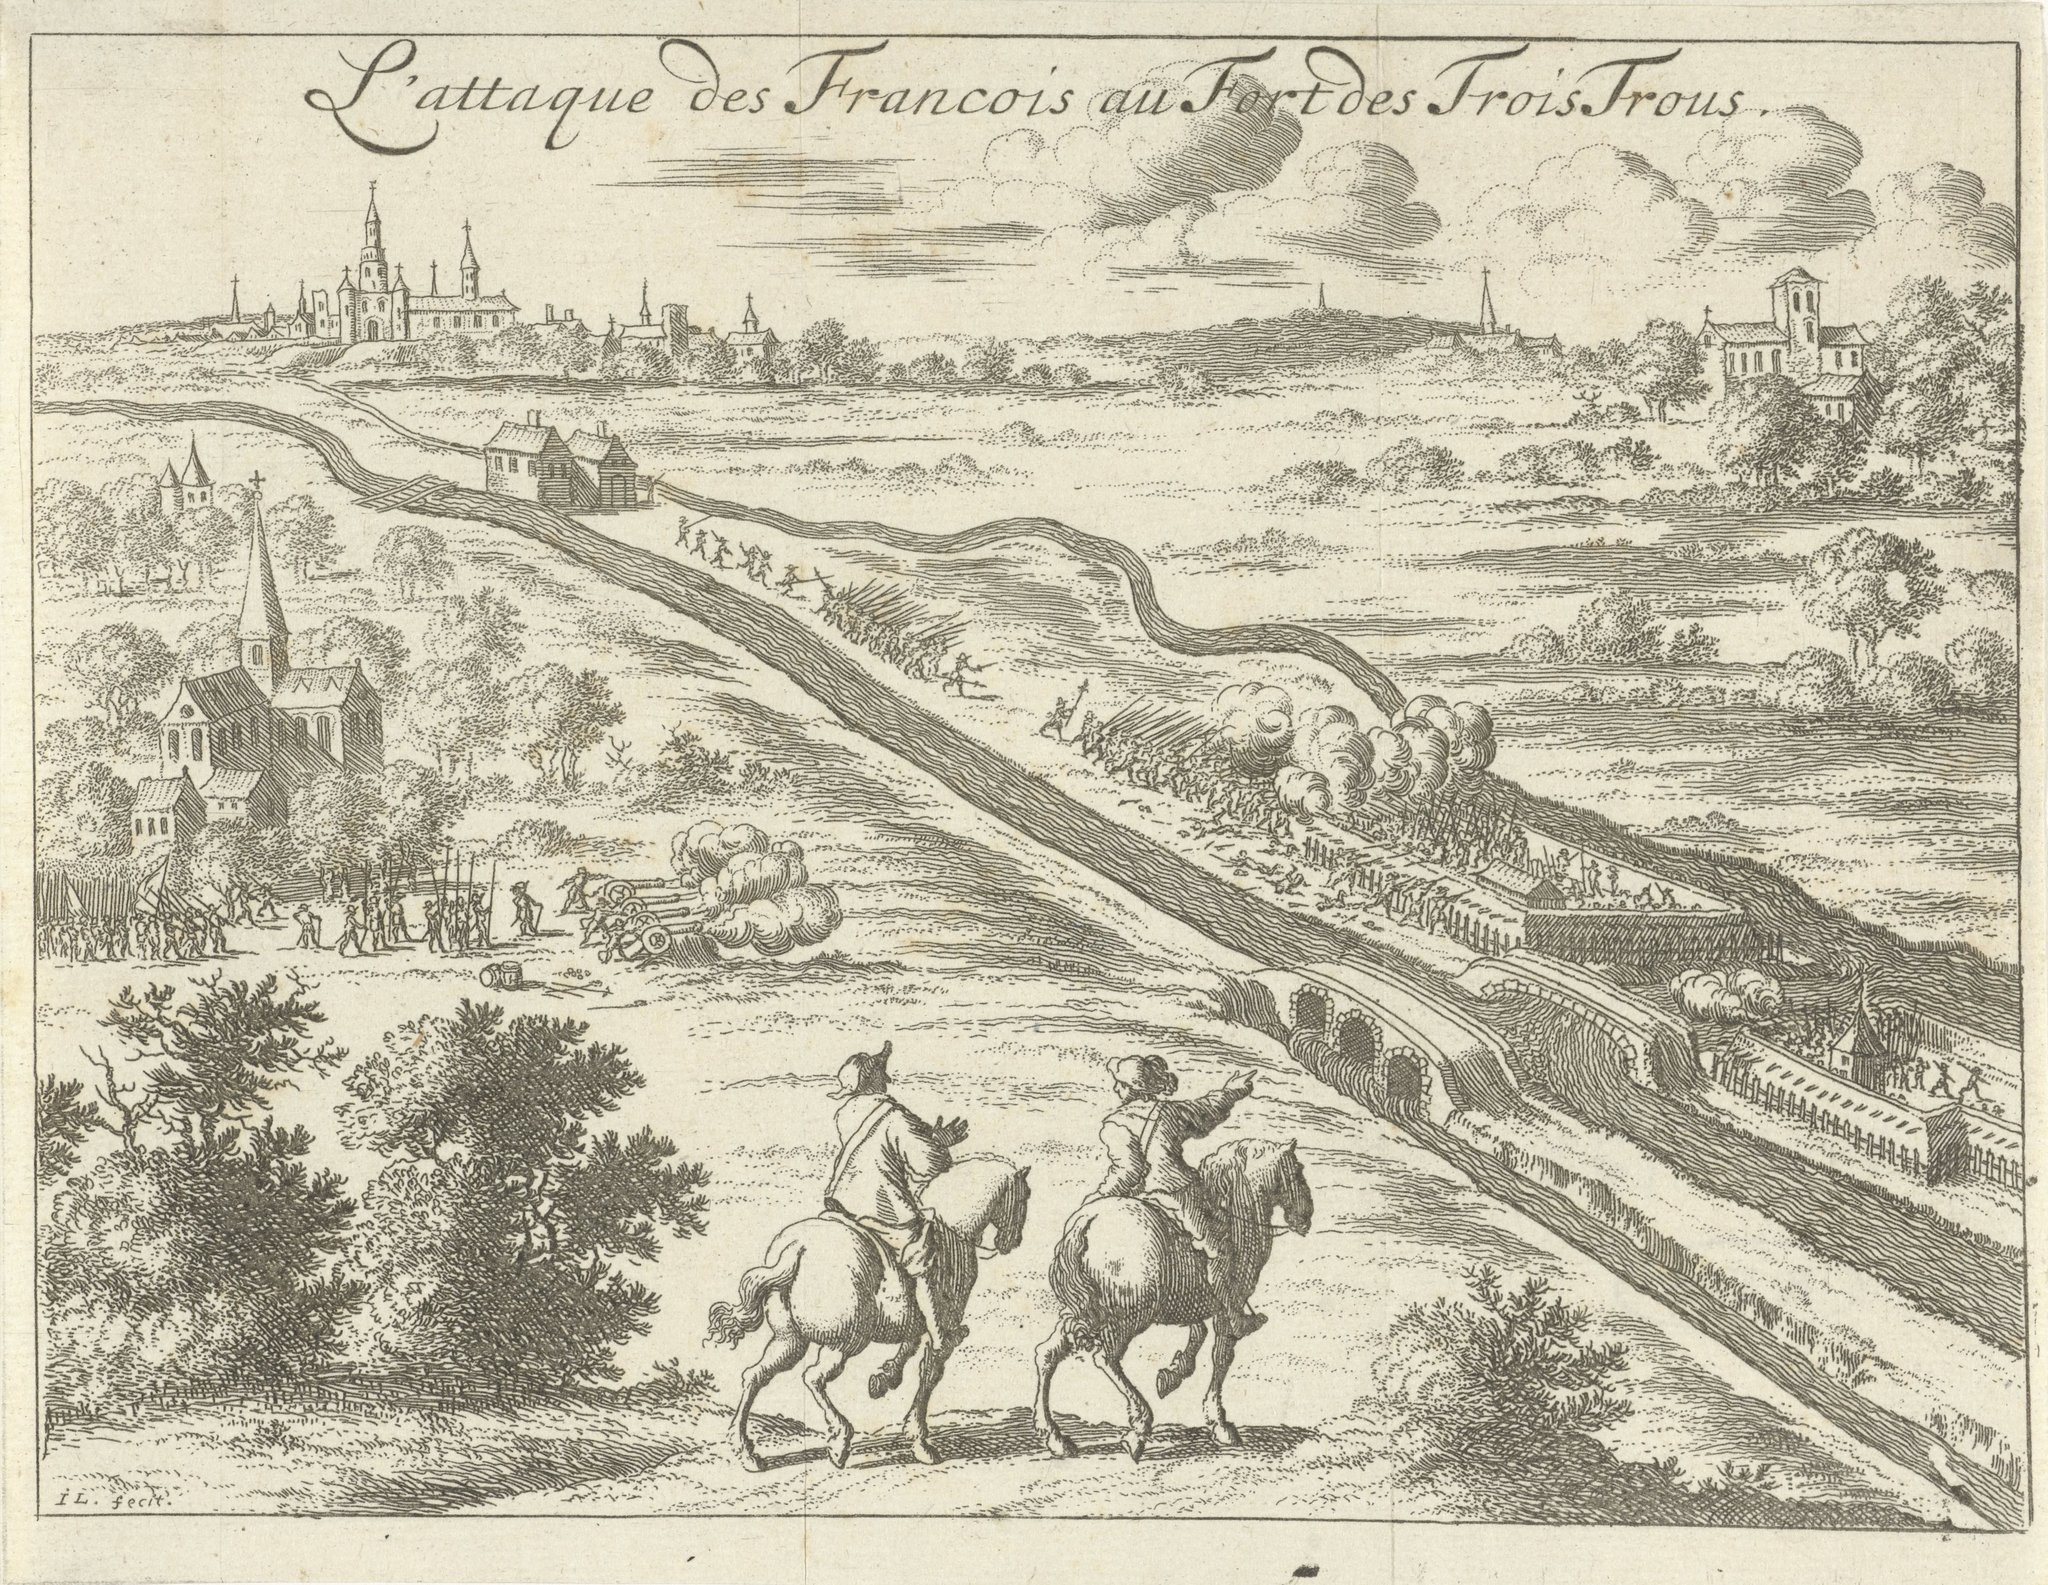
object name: print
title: L'attaque des Francois au Fort des Trois Trous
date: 1673-1686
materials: paper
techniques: etching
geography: amsterdam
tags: riding a horse, ass, or mule; rider, horseman, city-view, and landscape with man-made constructions, battle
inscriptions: collector's mark: Lugt 2228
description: Illustratie opgenomen in: Le Mercure hollandois, contenant les choses les plus remarquables, 13 delen. Amsterdam: Hendrick en Dirk Boom, 1673-1686, dl. VI, p. 436.